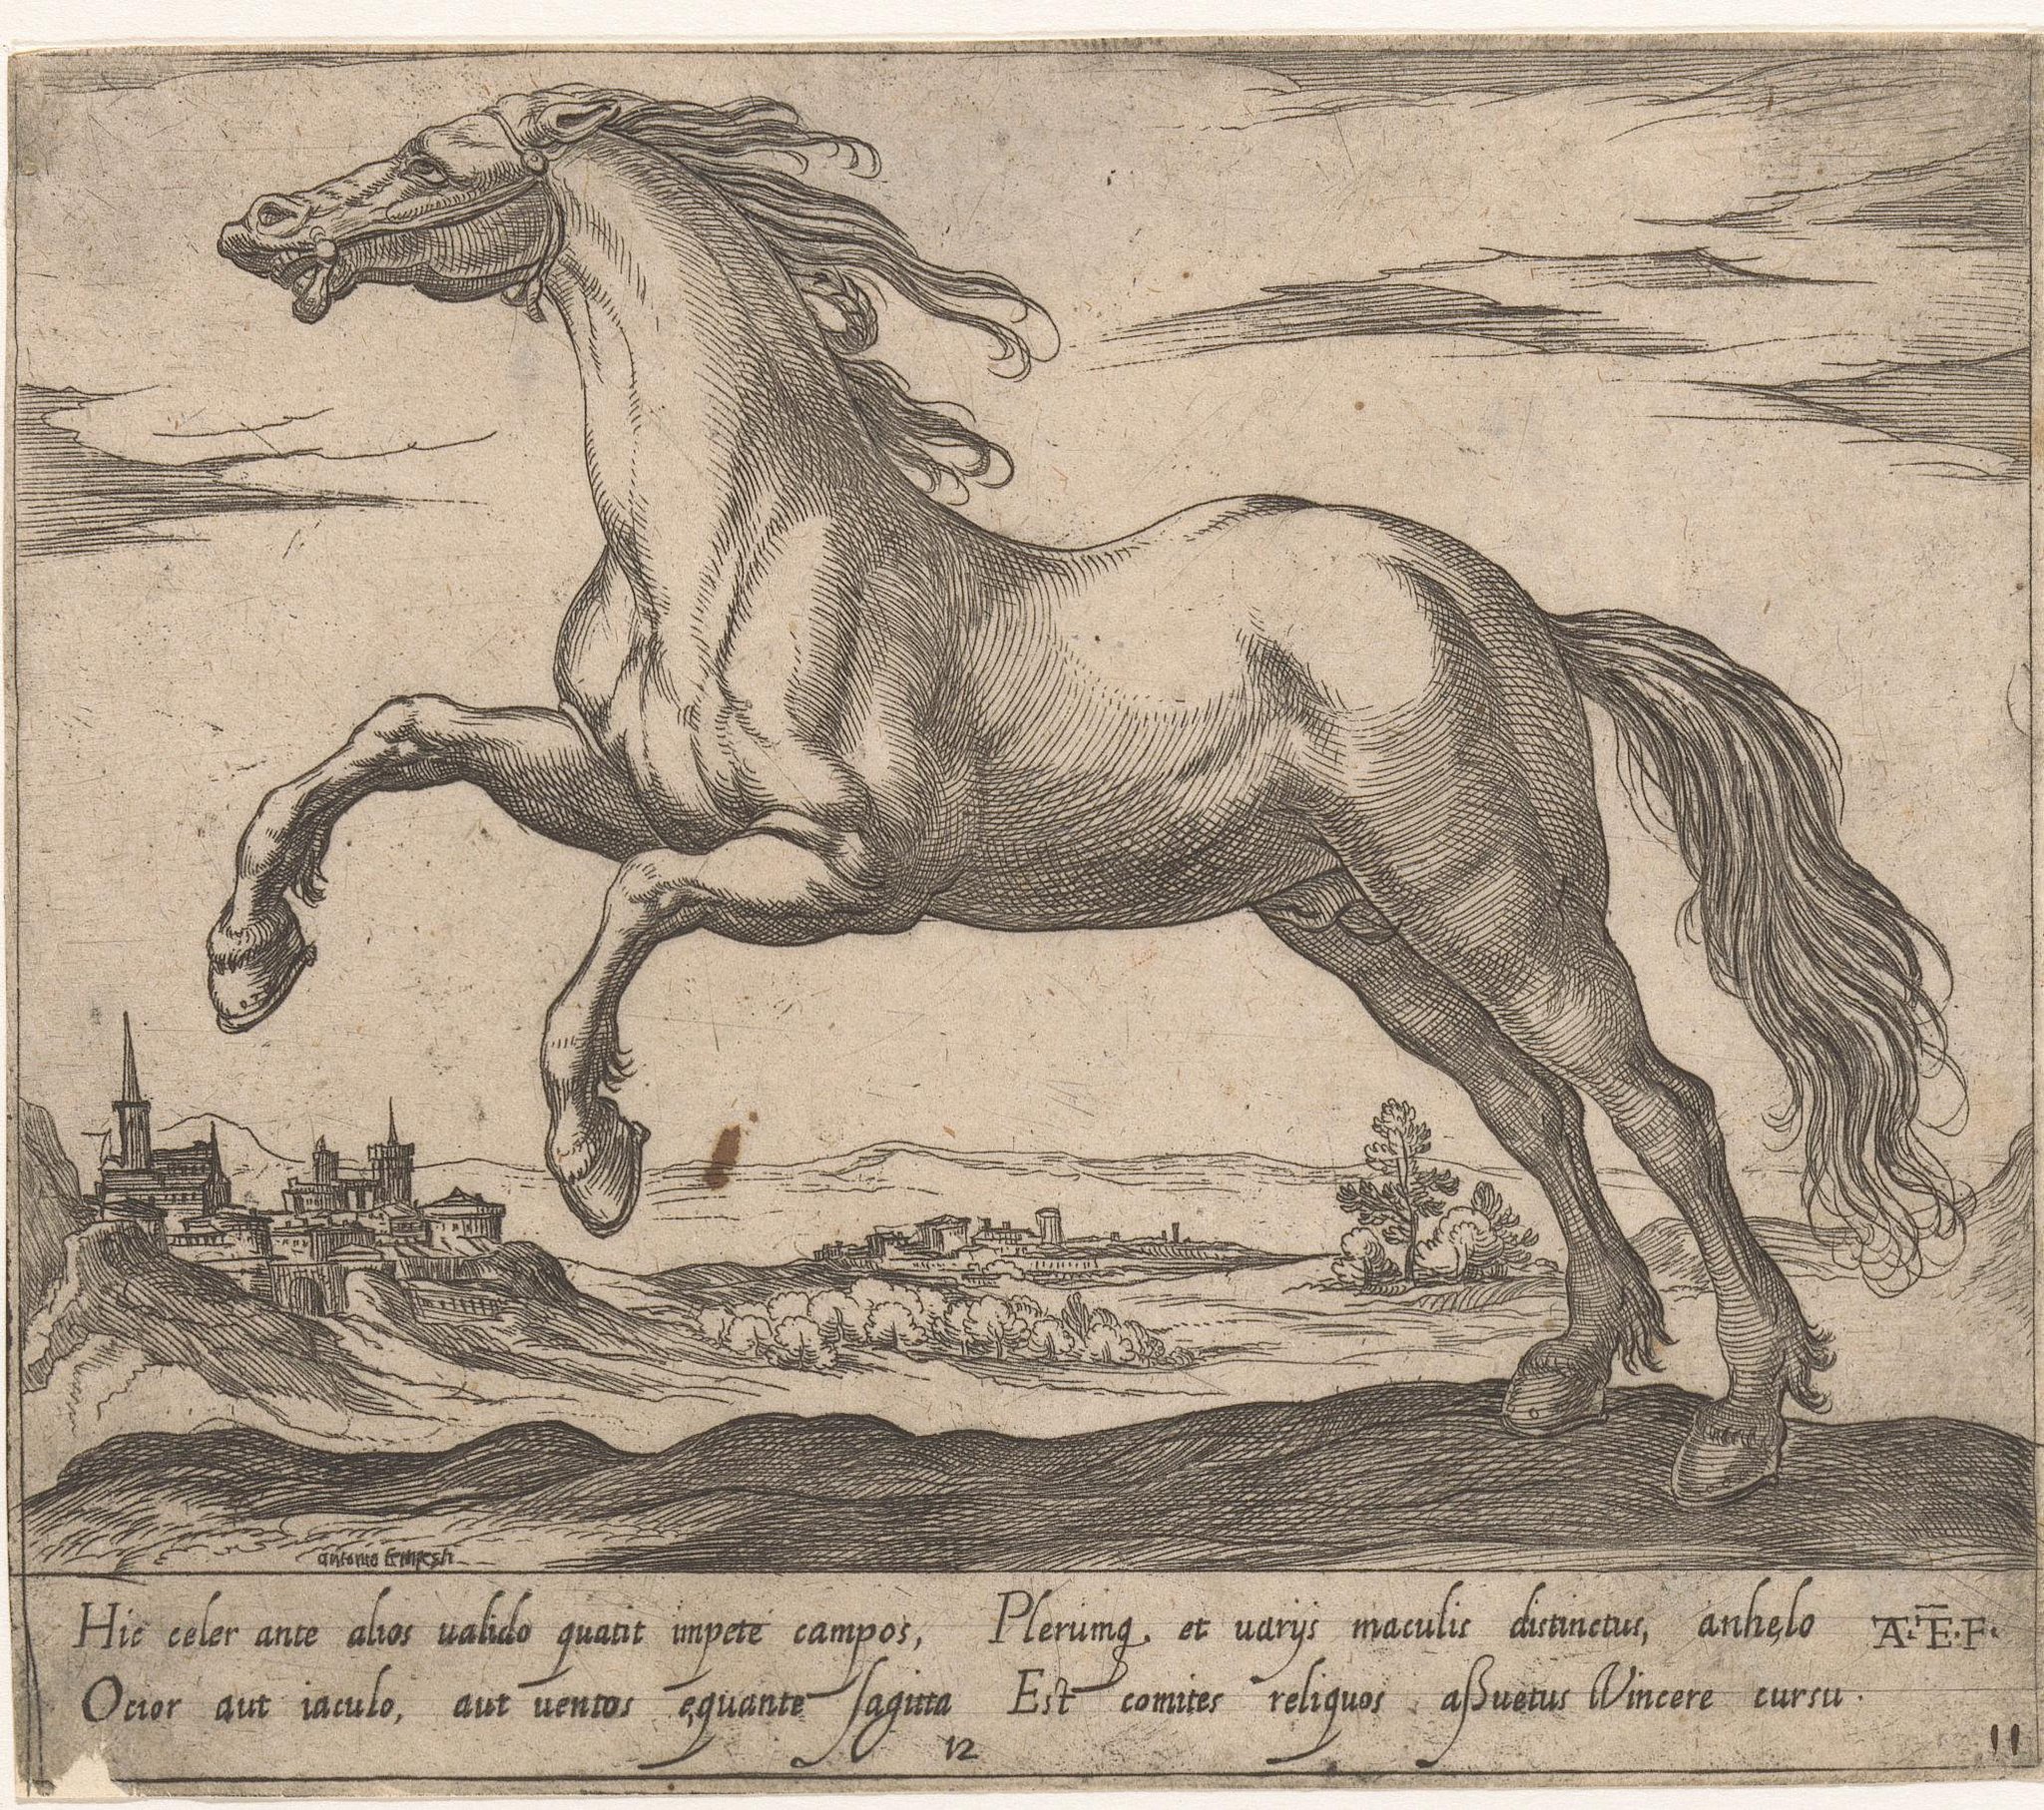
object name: print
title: Paarden uit verschillende landen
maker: antonio tempesta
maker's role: draughtsman, painter, print maker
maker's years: 1555-1630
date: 1590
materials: paper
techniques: etching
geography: italy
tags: horse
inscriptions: number: ‘11’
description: Deze prent maakt deel uit van een reeks van 28 prenten van paarden (+ titelprent en opdracht).